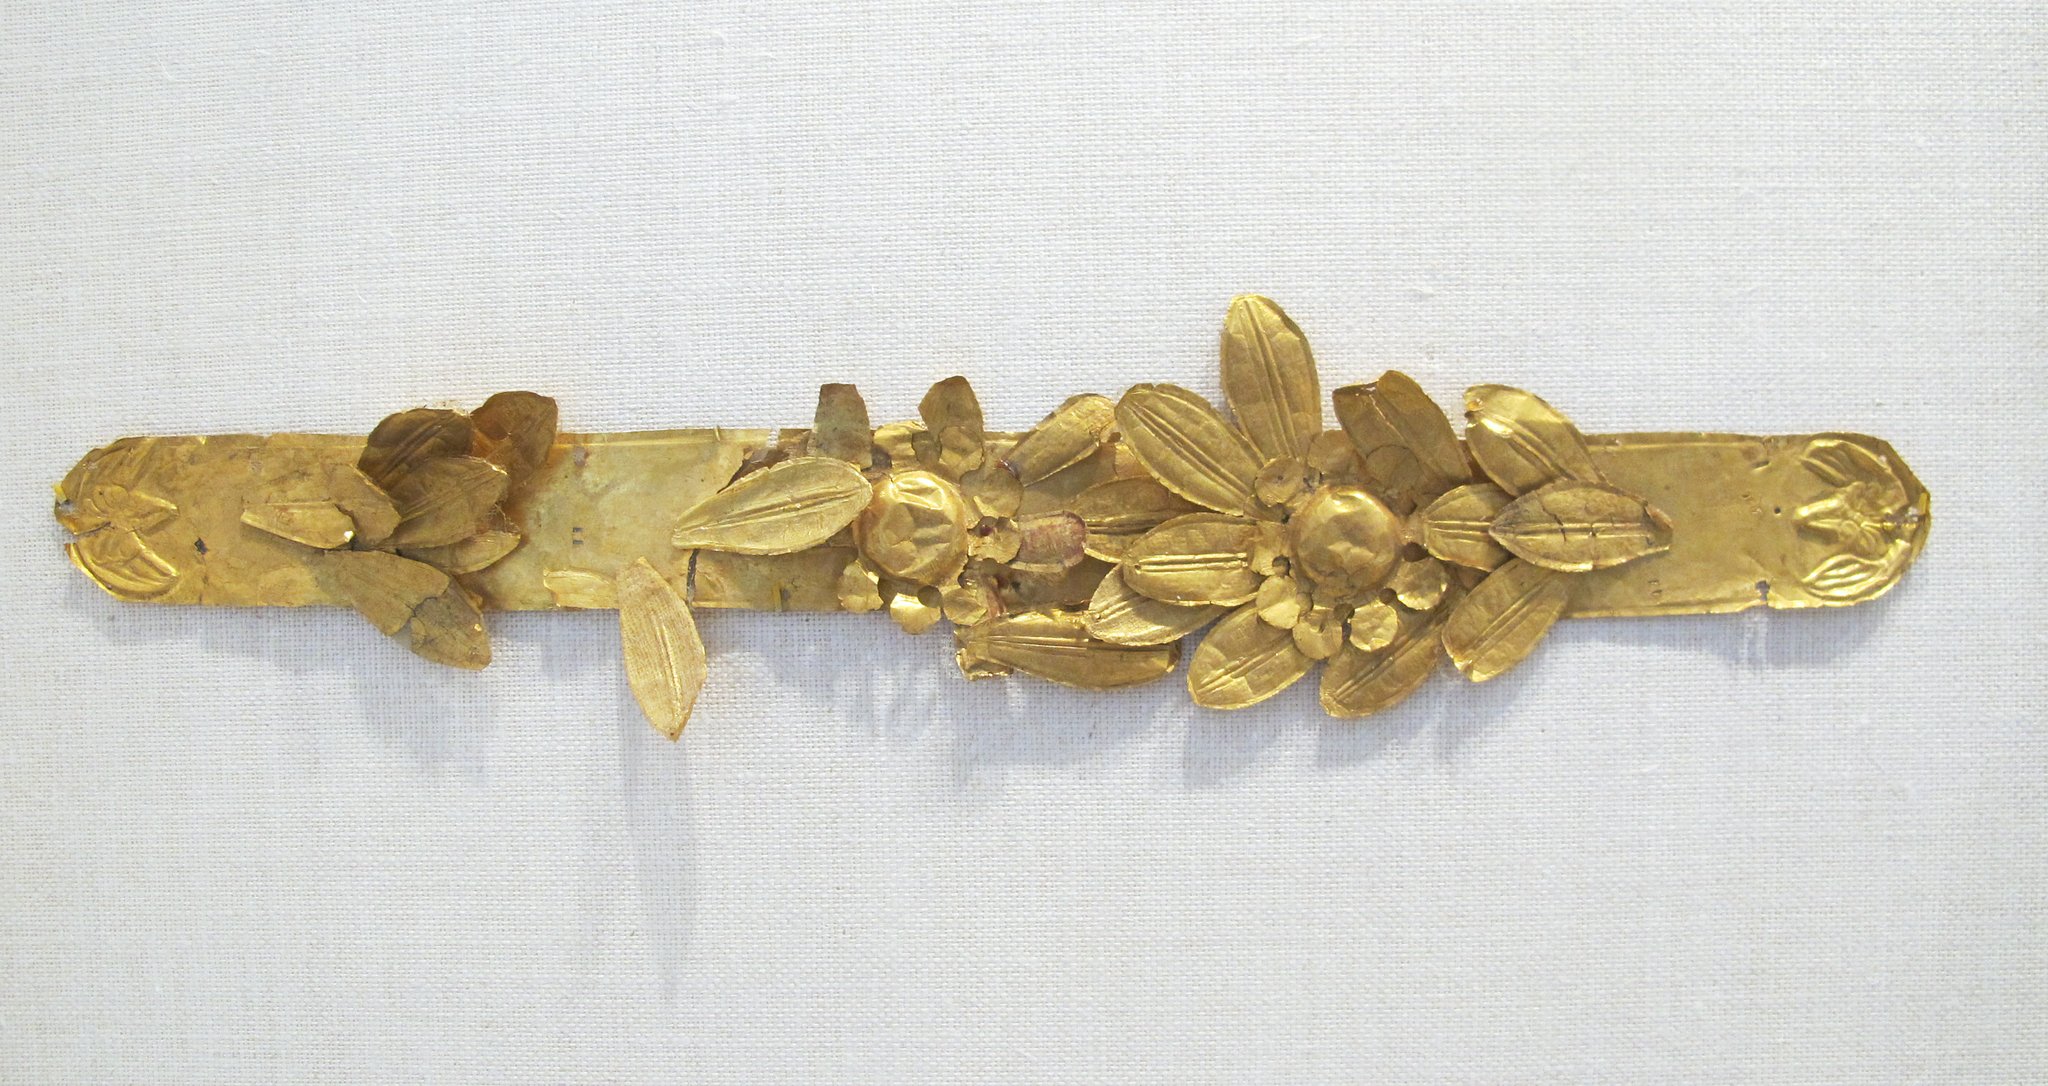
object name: wreath, funerary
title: Gold wreath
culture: etruscan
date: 400-201 BCE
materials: gold